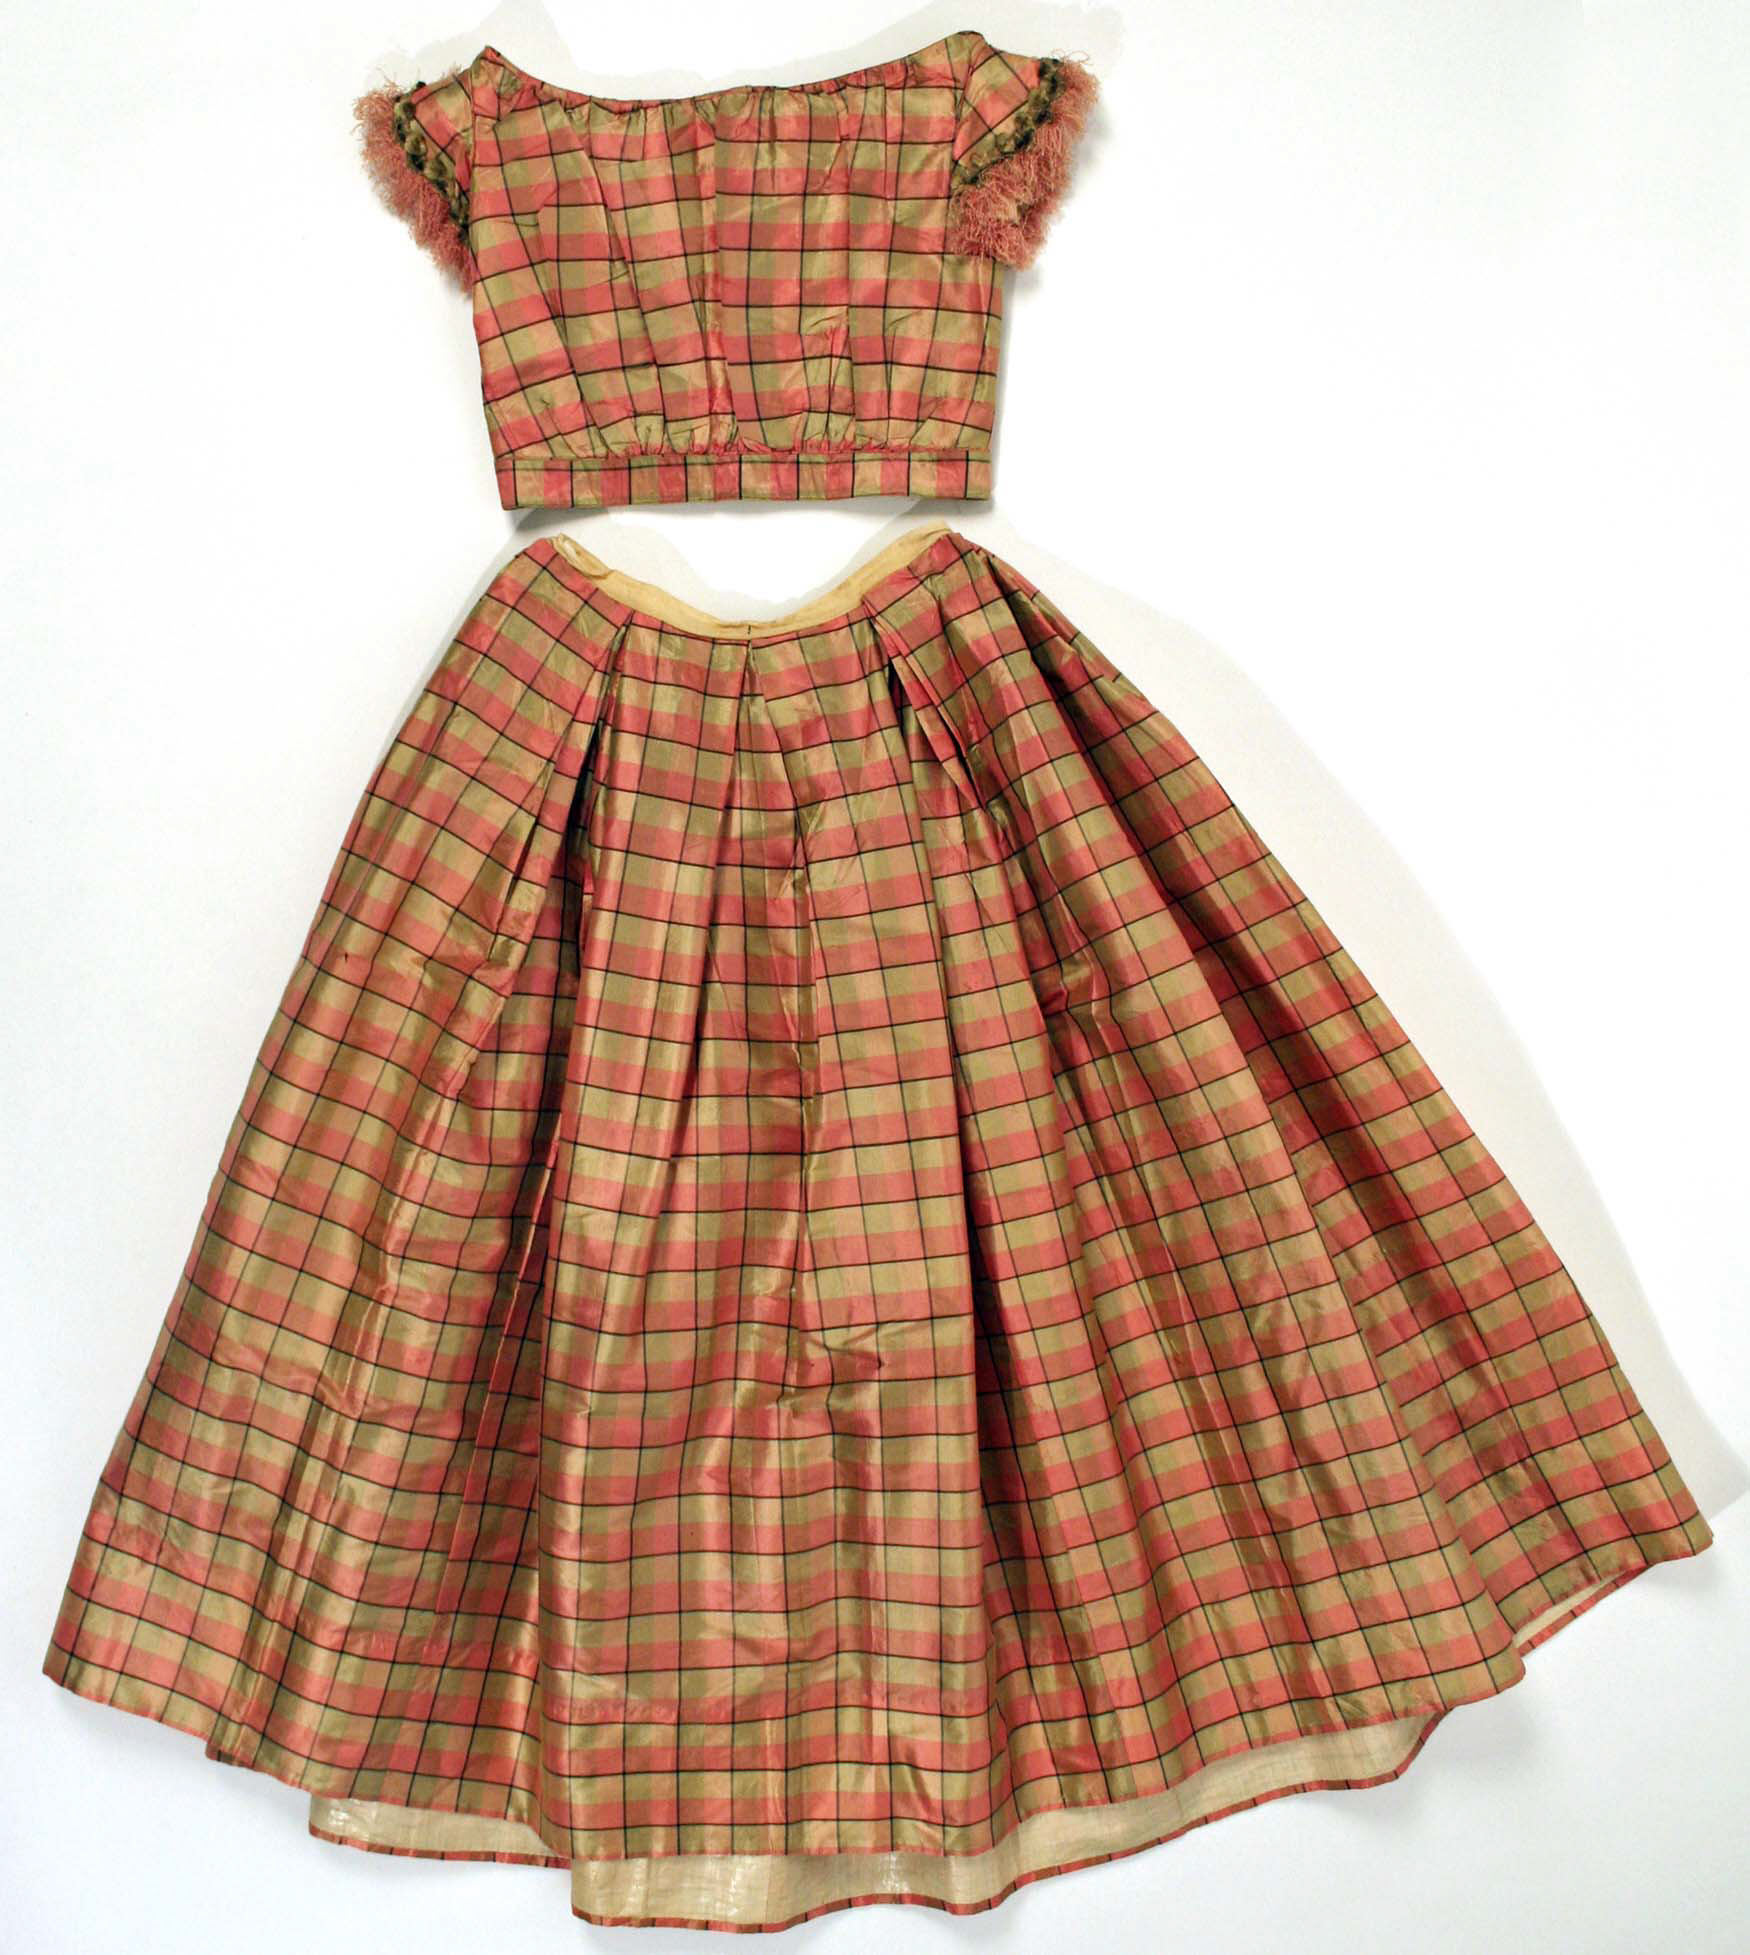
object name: dress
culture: american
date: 1850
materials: silk